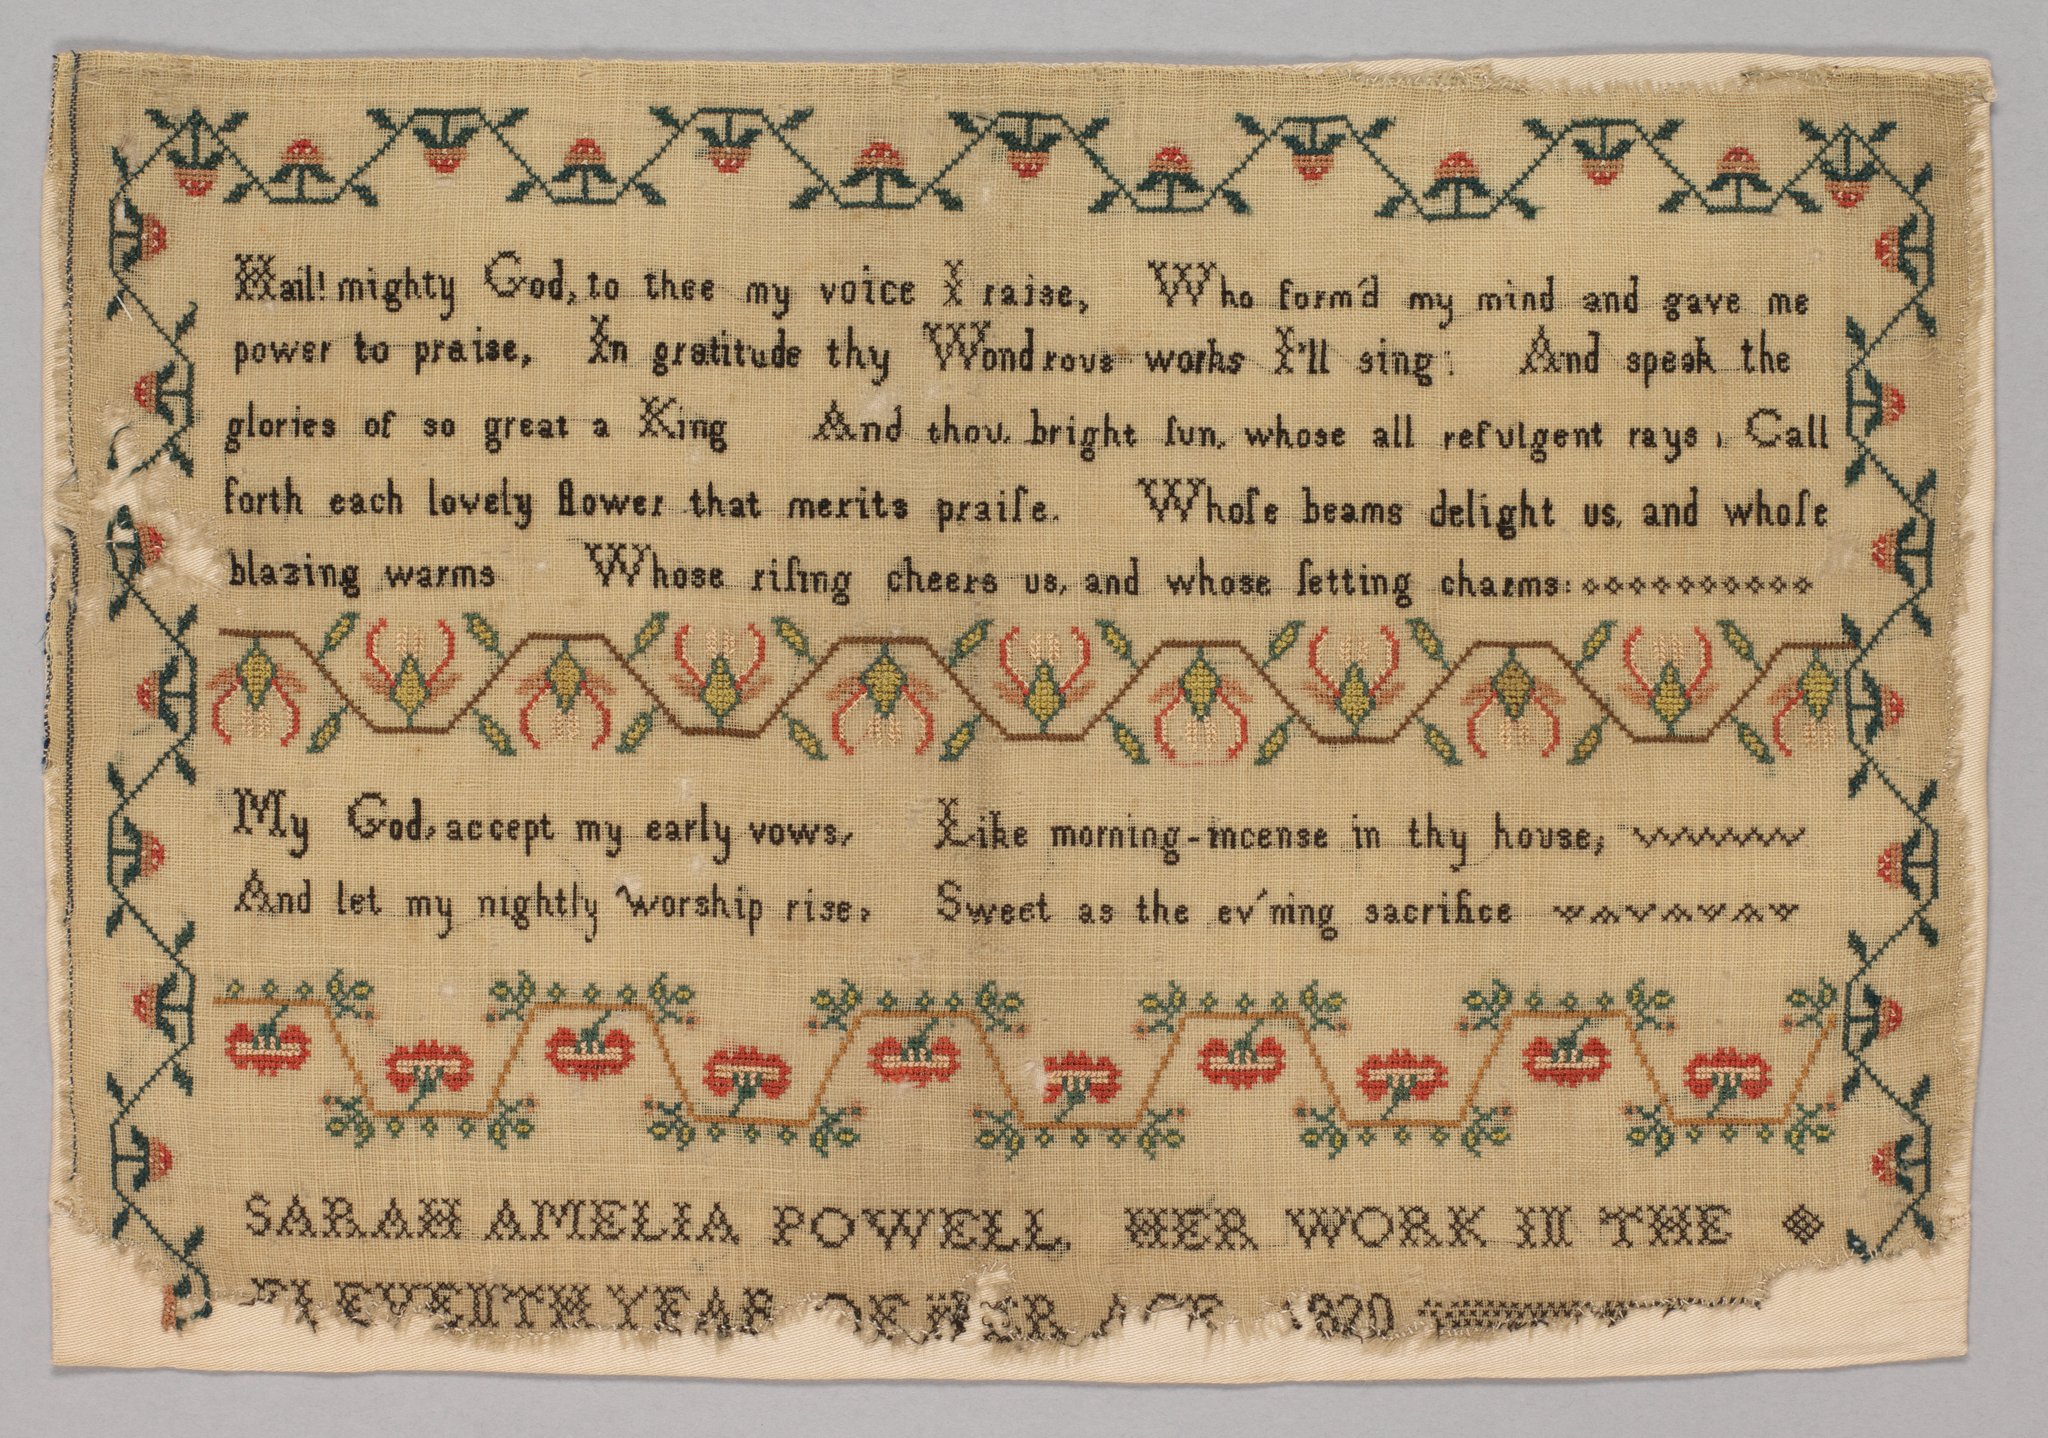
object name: sampler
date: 1820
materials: canvas, silk, wool